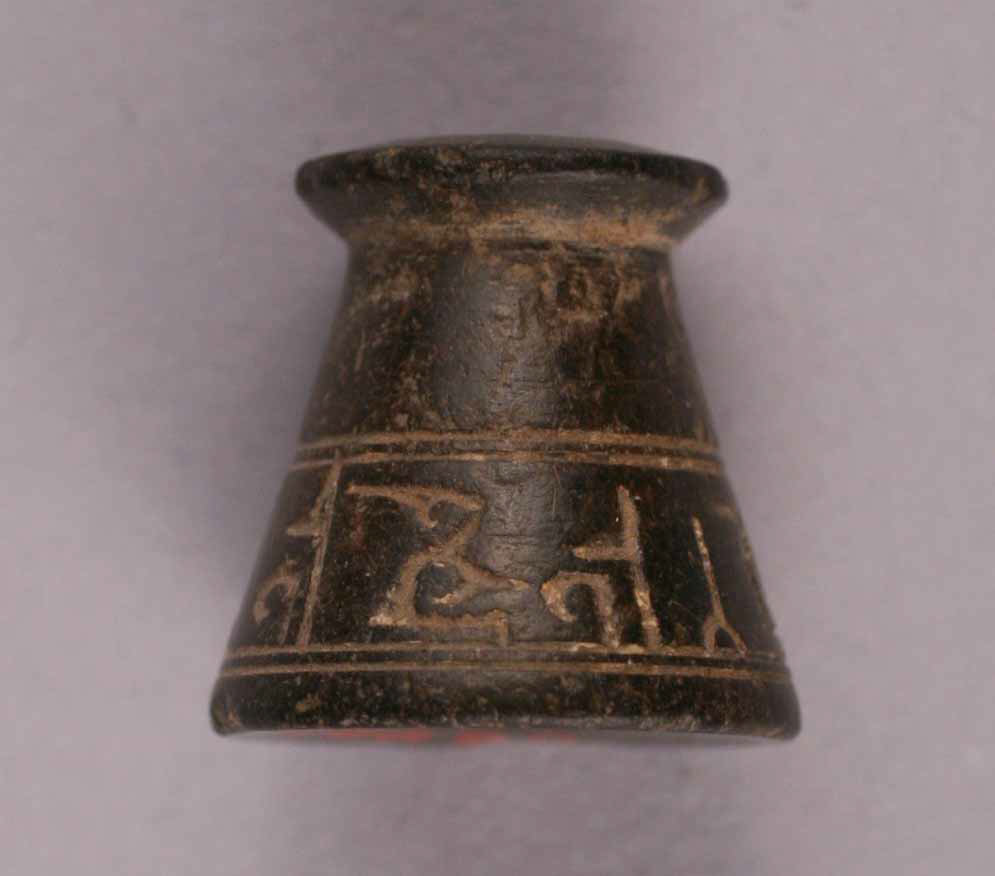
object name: button or bead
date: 901-1100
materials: stone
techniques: incising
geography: iran